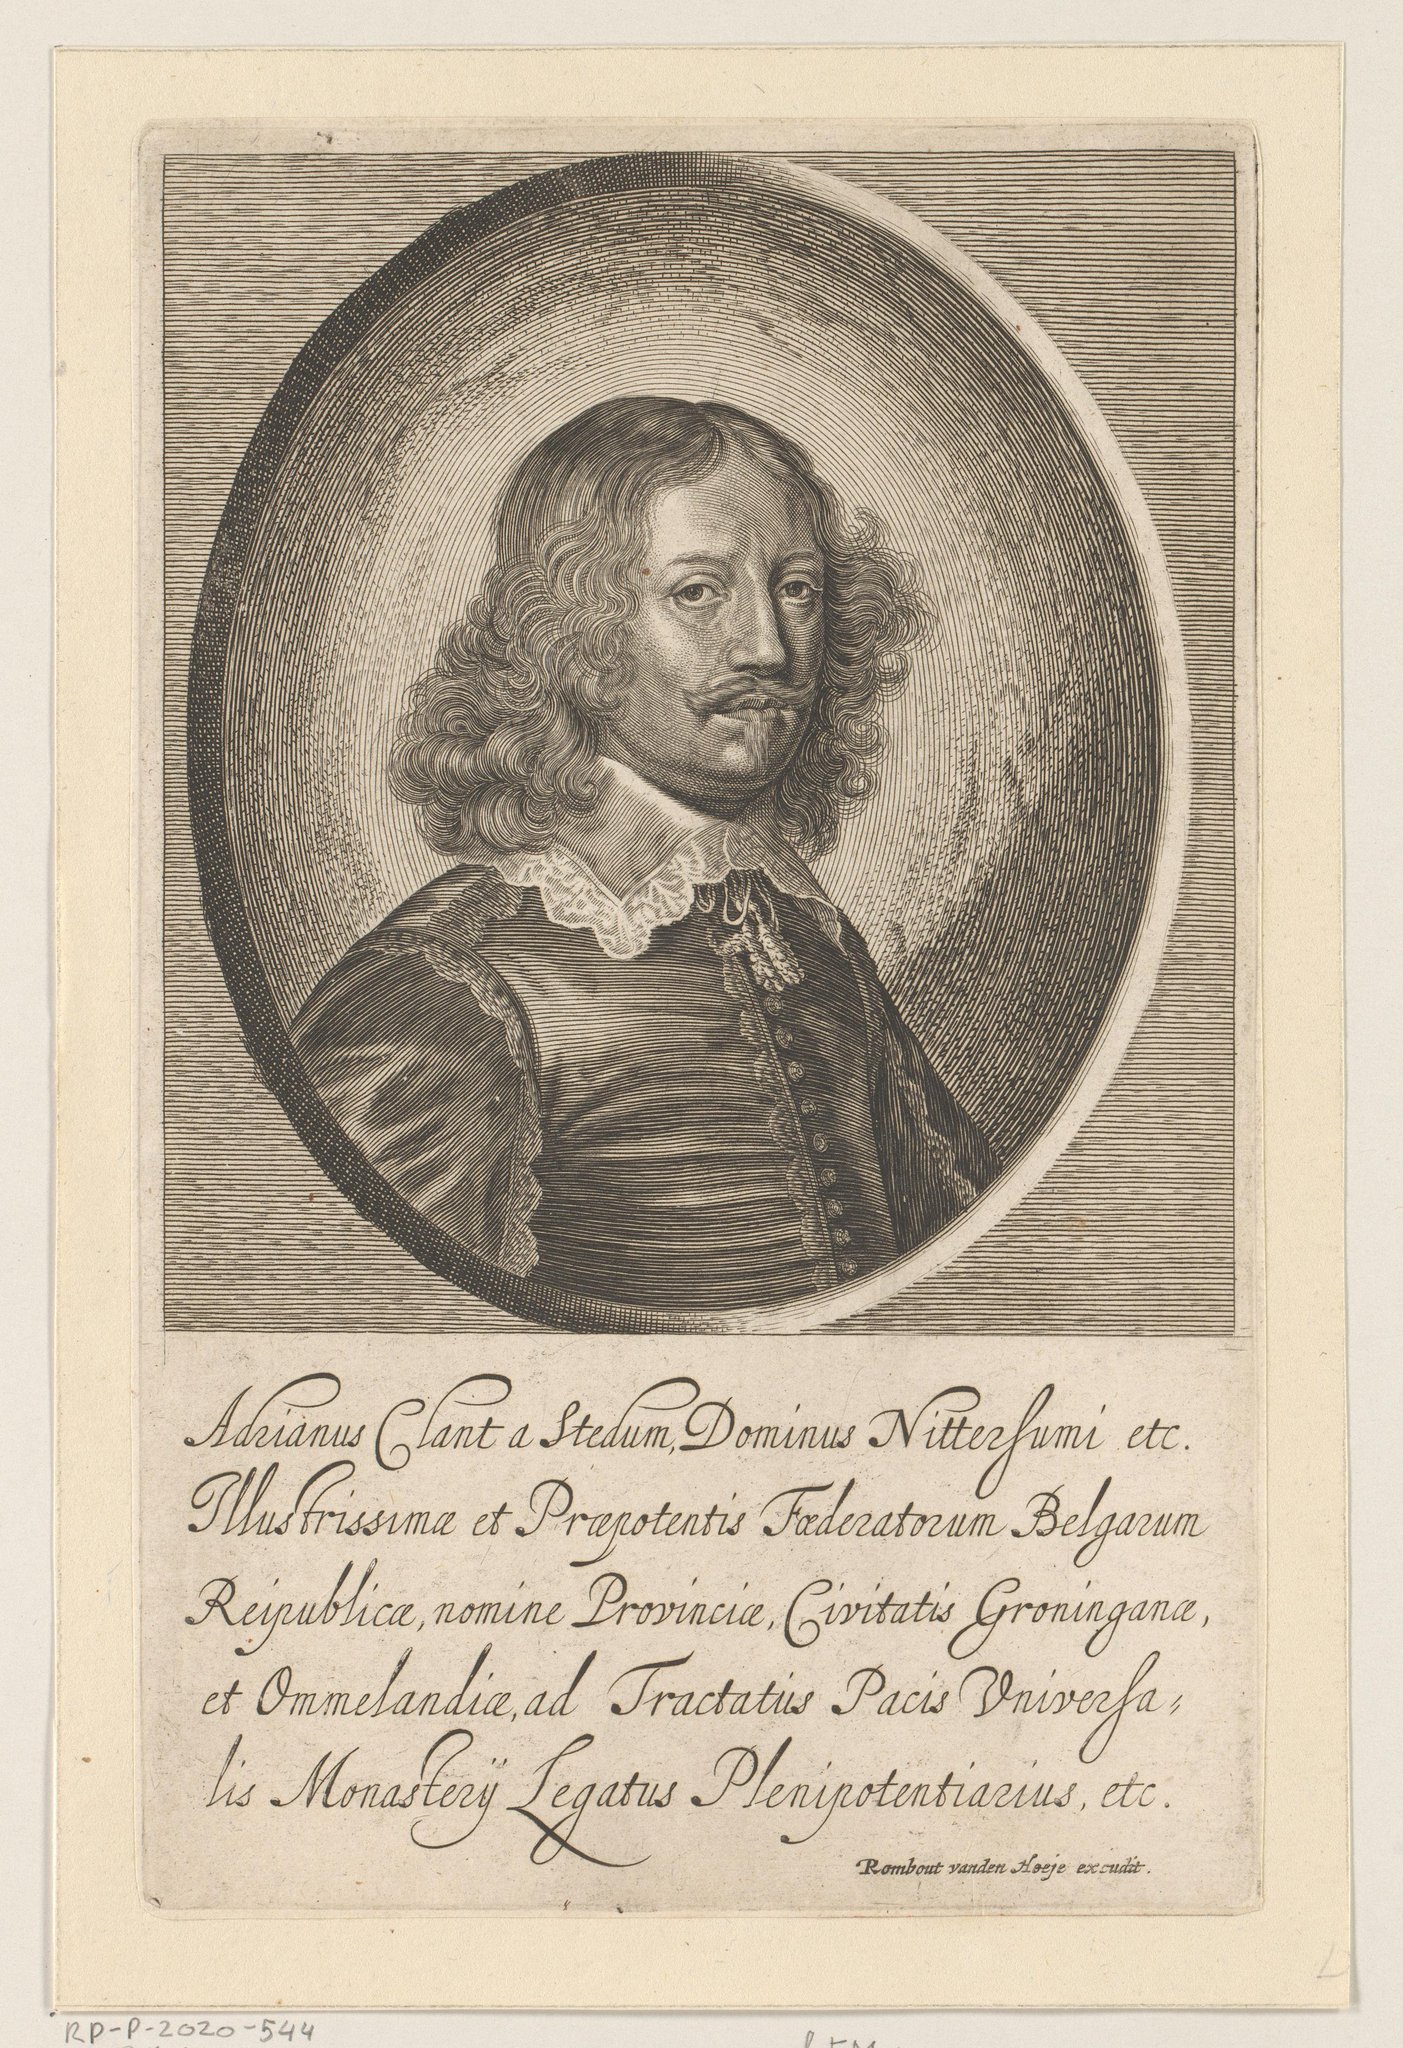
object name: print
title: Pacificatores orbis Christiani in Westphaliam missi anno 1641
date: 1644-1671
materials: paper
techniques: engraving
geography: amsterdam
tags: historical persons, diplomacy, diplomat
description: Prent maakt deel uit van een serie van 43 prenten. Eerdere staat van prent gebruikt in de serie 'Icones legatorum Monasterii et Osnabrugae existentium', uitgegeven door Abraham van Waesbergen in Amsterdam.